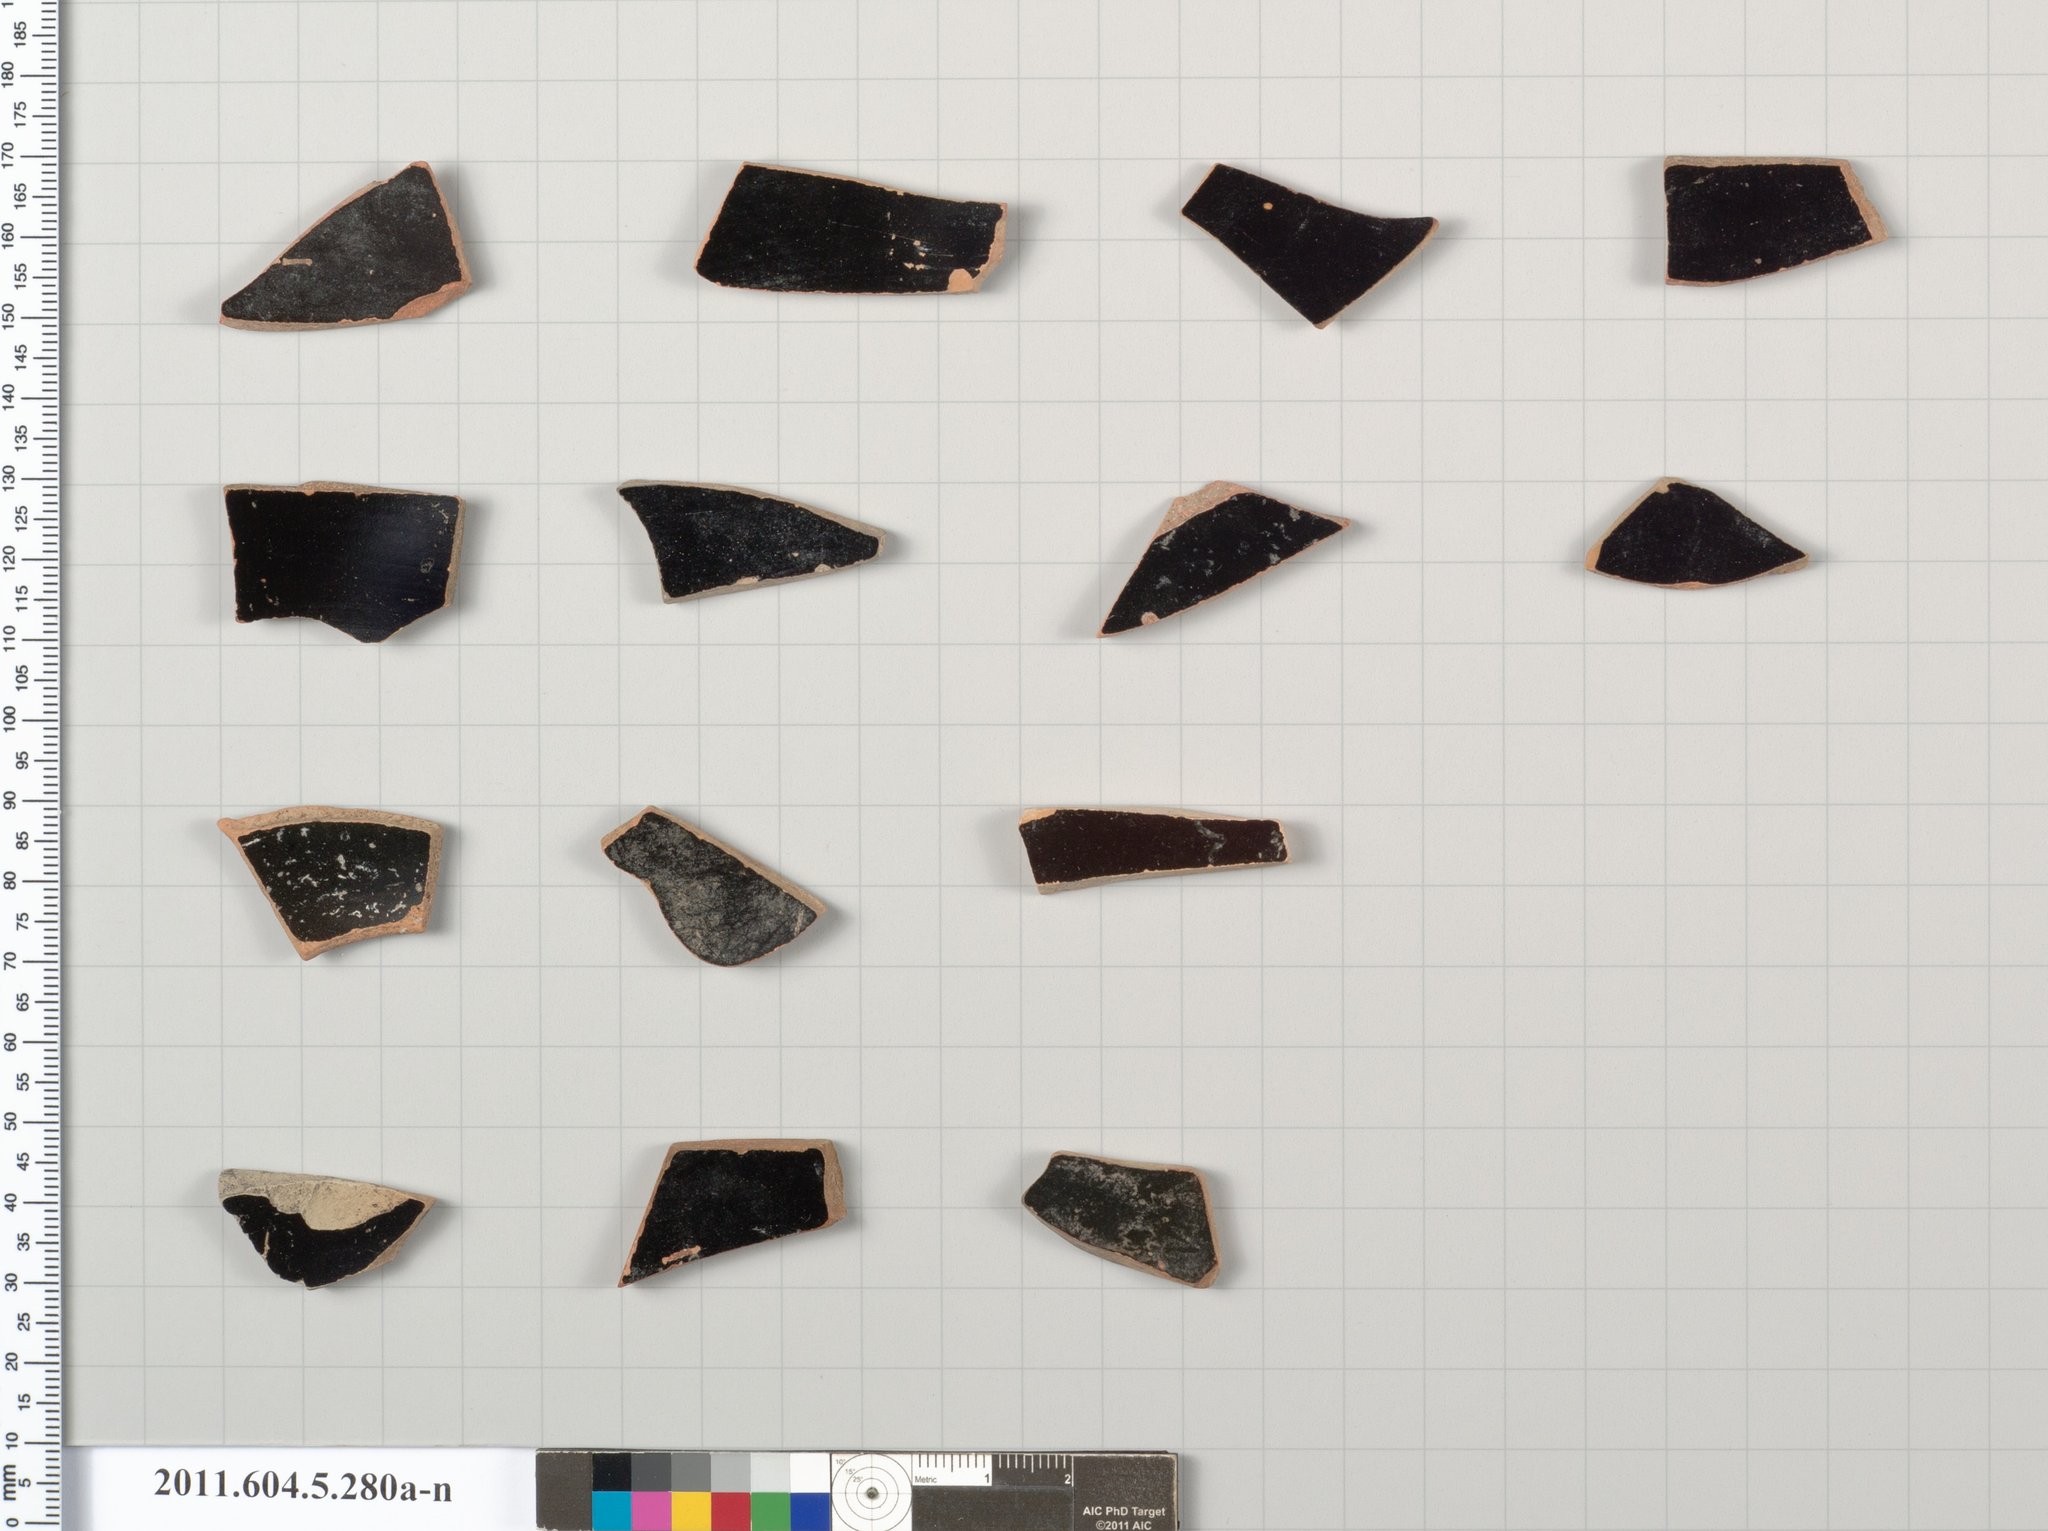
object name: kylix fragment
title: Terracotta fragments of kylikes (drinking cups)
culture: greek, attic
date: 600-401 BCE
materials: terracotta